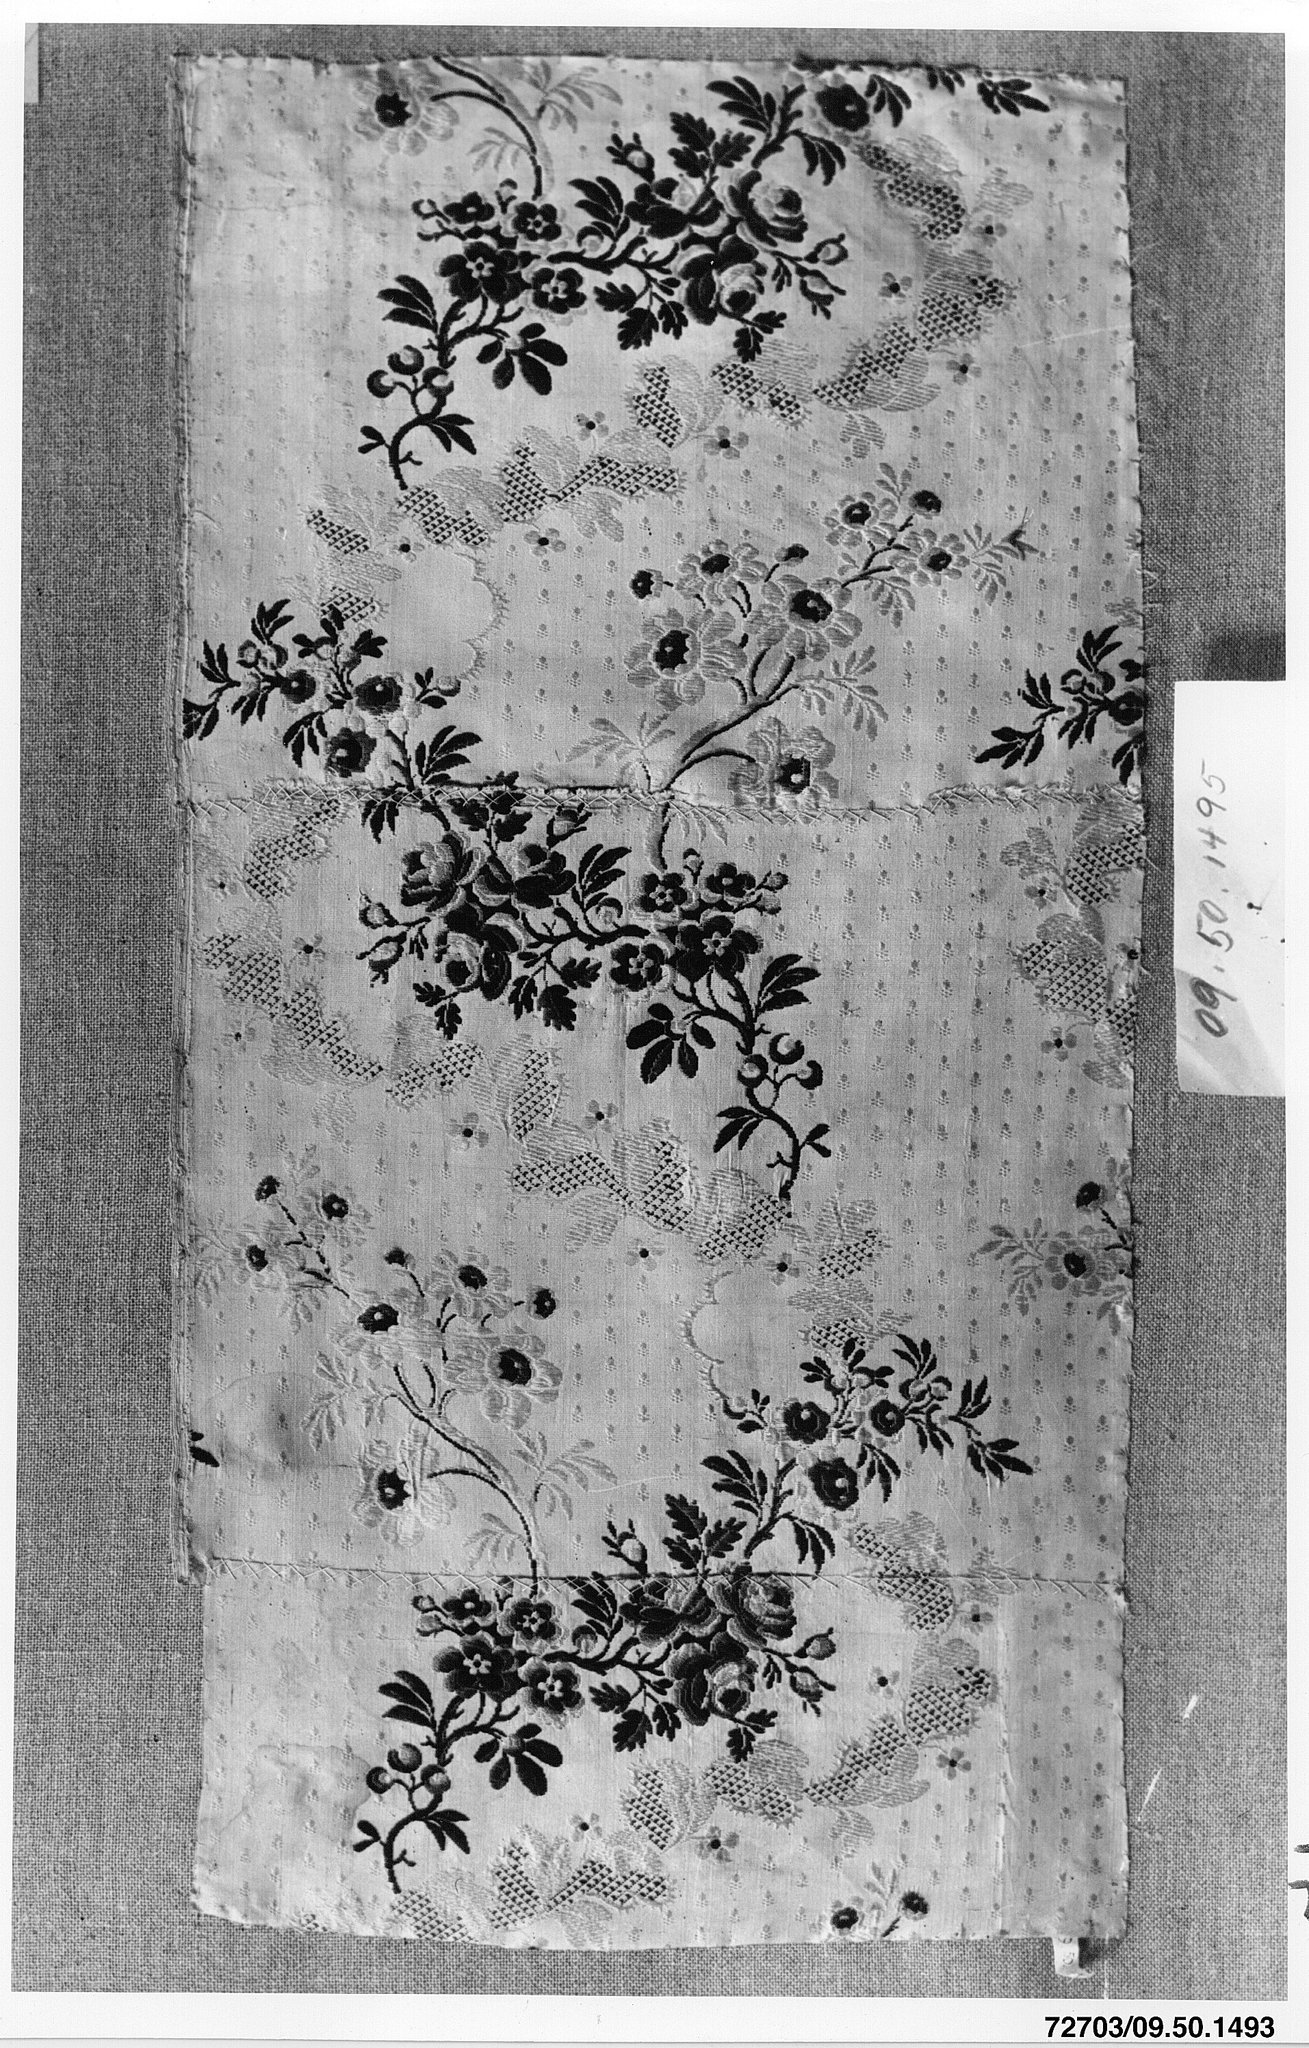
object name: piece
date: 1750-1760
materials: silk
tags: flowers